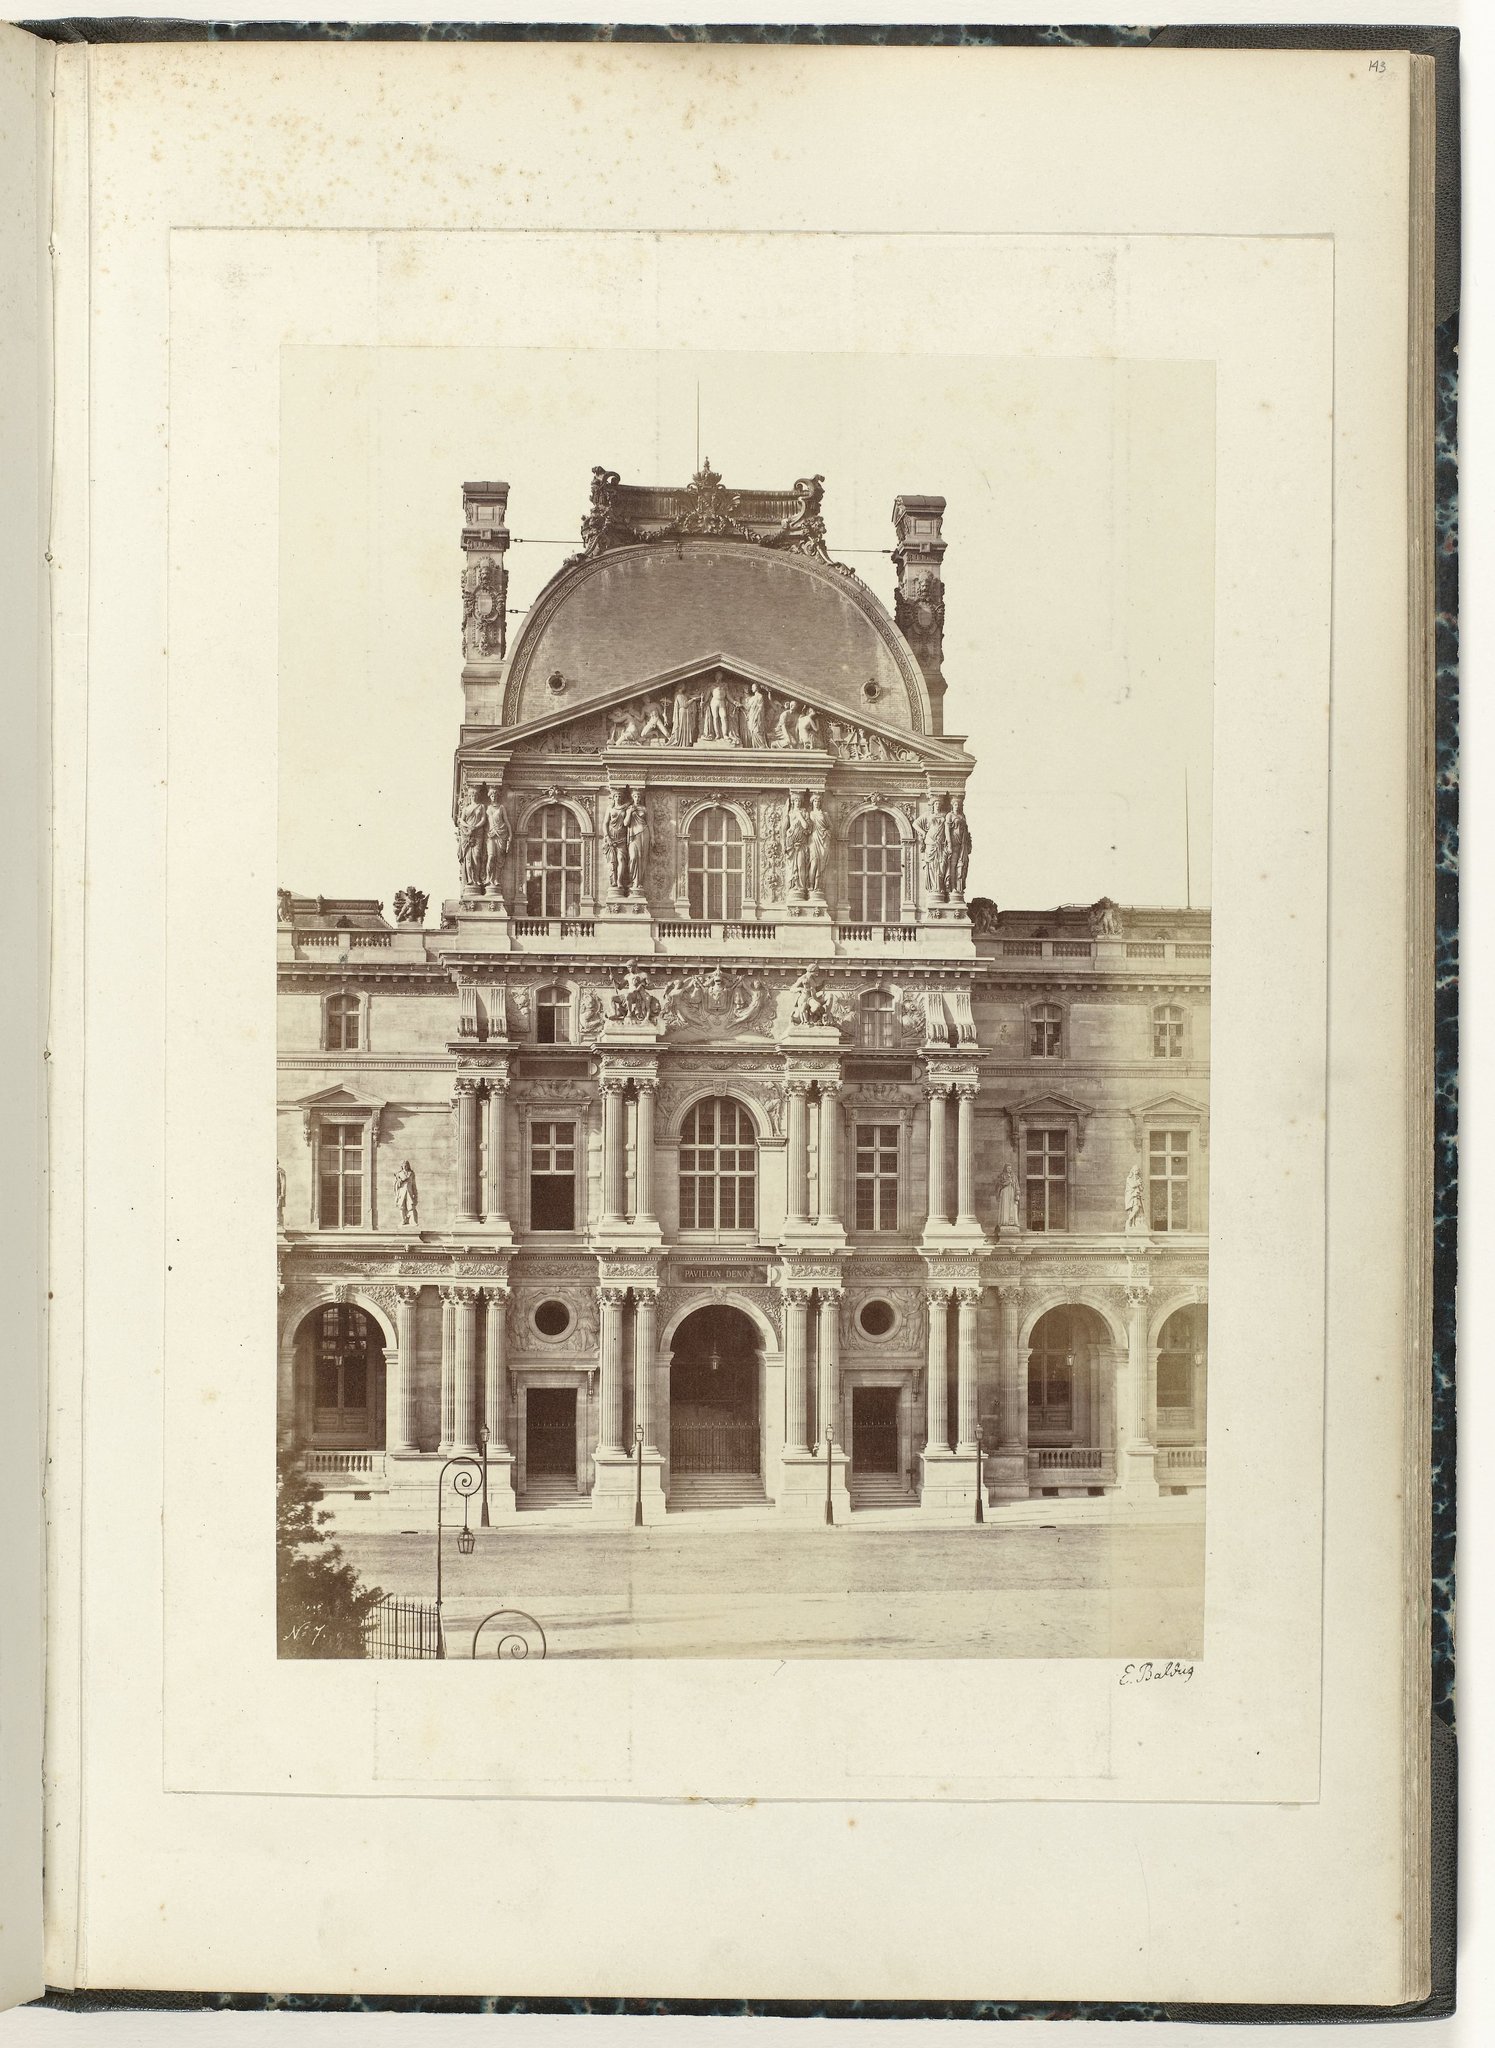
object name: photograph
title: Pavillon Denon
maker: édouard denis baldus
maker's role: fotograaf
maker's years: 1813-1889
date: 1857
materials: cardboard, paper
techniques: salted paper print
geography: paris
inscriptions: name: ‘E. Baldus’